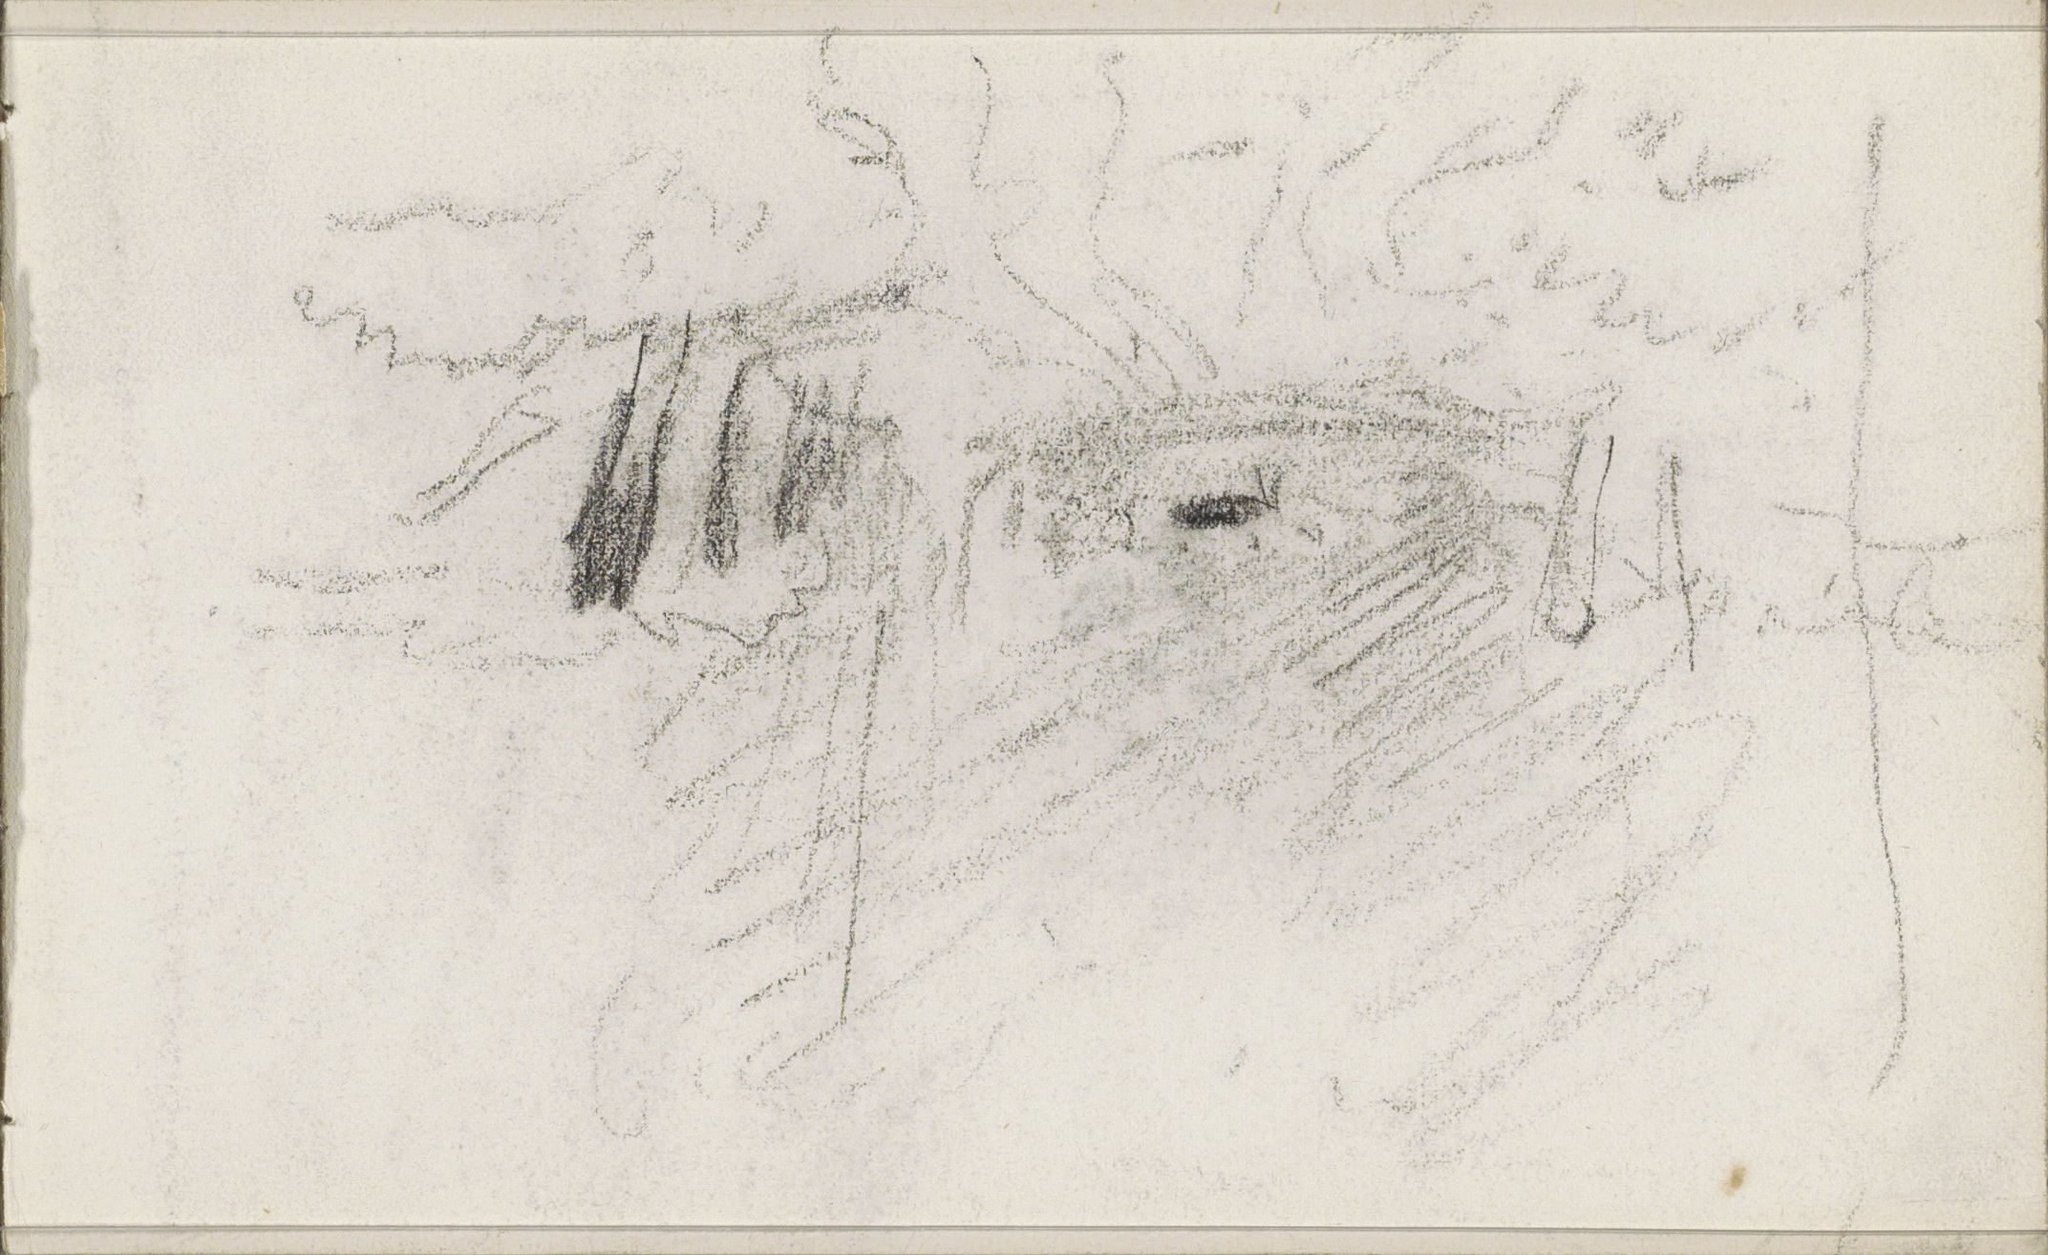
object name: sketchbook leaf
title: Pad in een landschap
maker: anton mauve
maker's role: draughtsman, painter, print maker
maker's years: 1838-1888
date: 1848-1888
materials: chalk, paper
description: Blad 29 recto uit een schetsboek met 43 bladen.